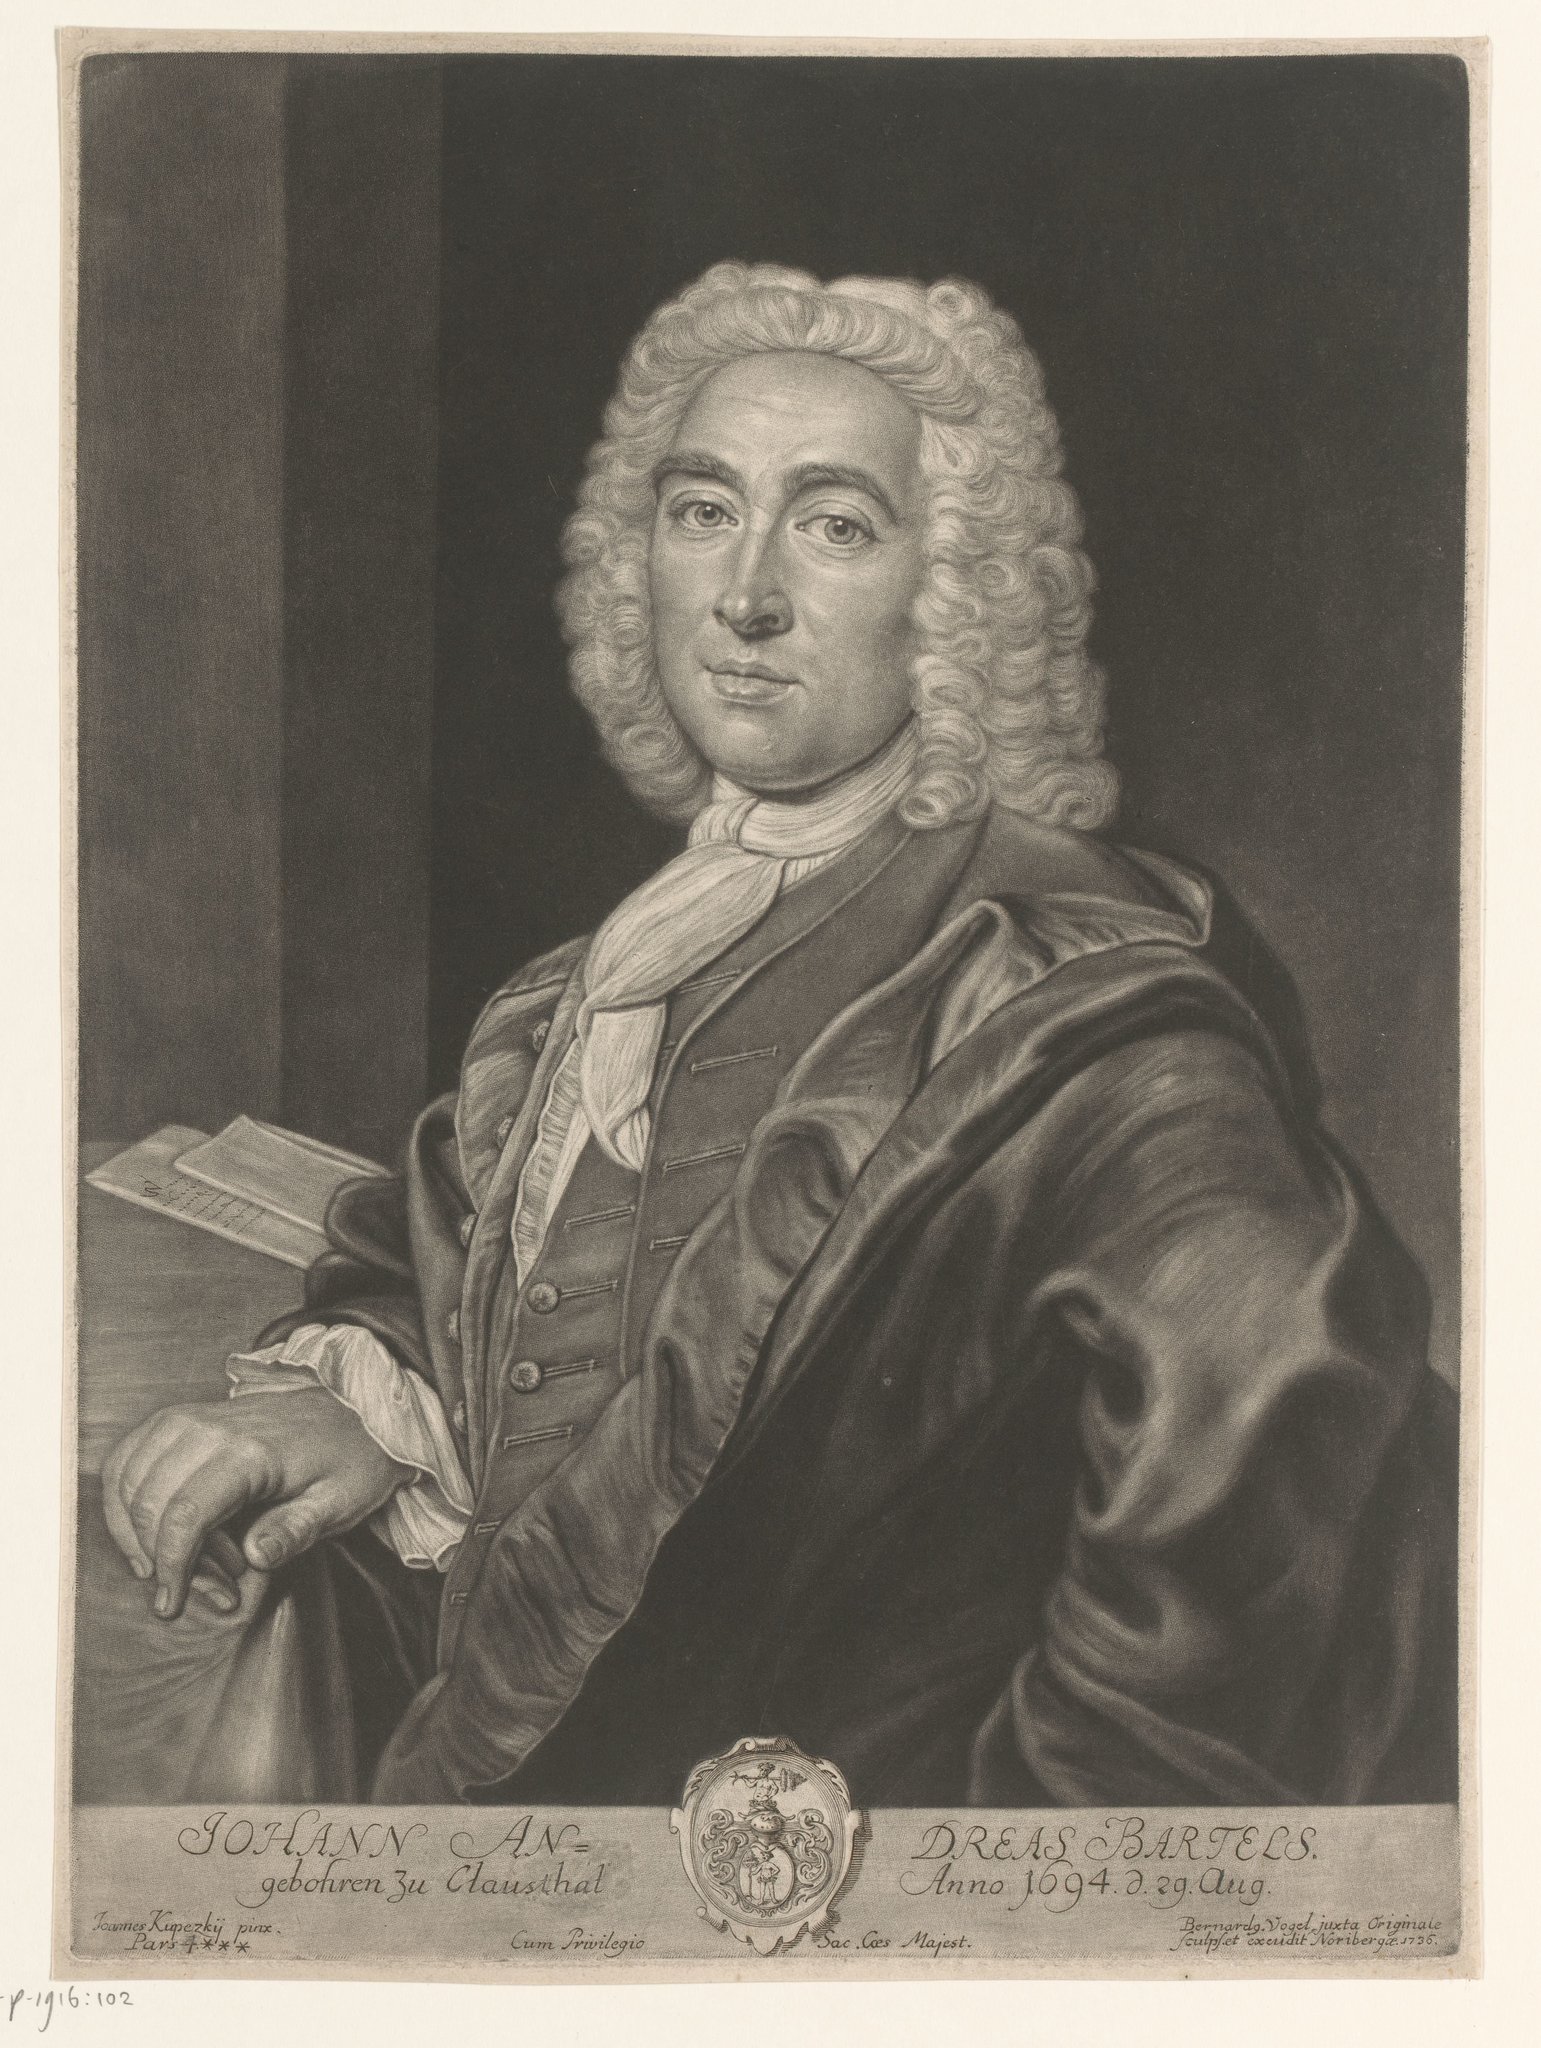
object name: print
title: Portret van Johann Andreas Bartels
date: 1736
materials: paper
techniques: mezzotint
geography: nuremberg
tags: historical persons, armorial bearing, heraldry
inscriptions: collector's mark: Lugt 2228